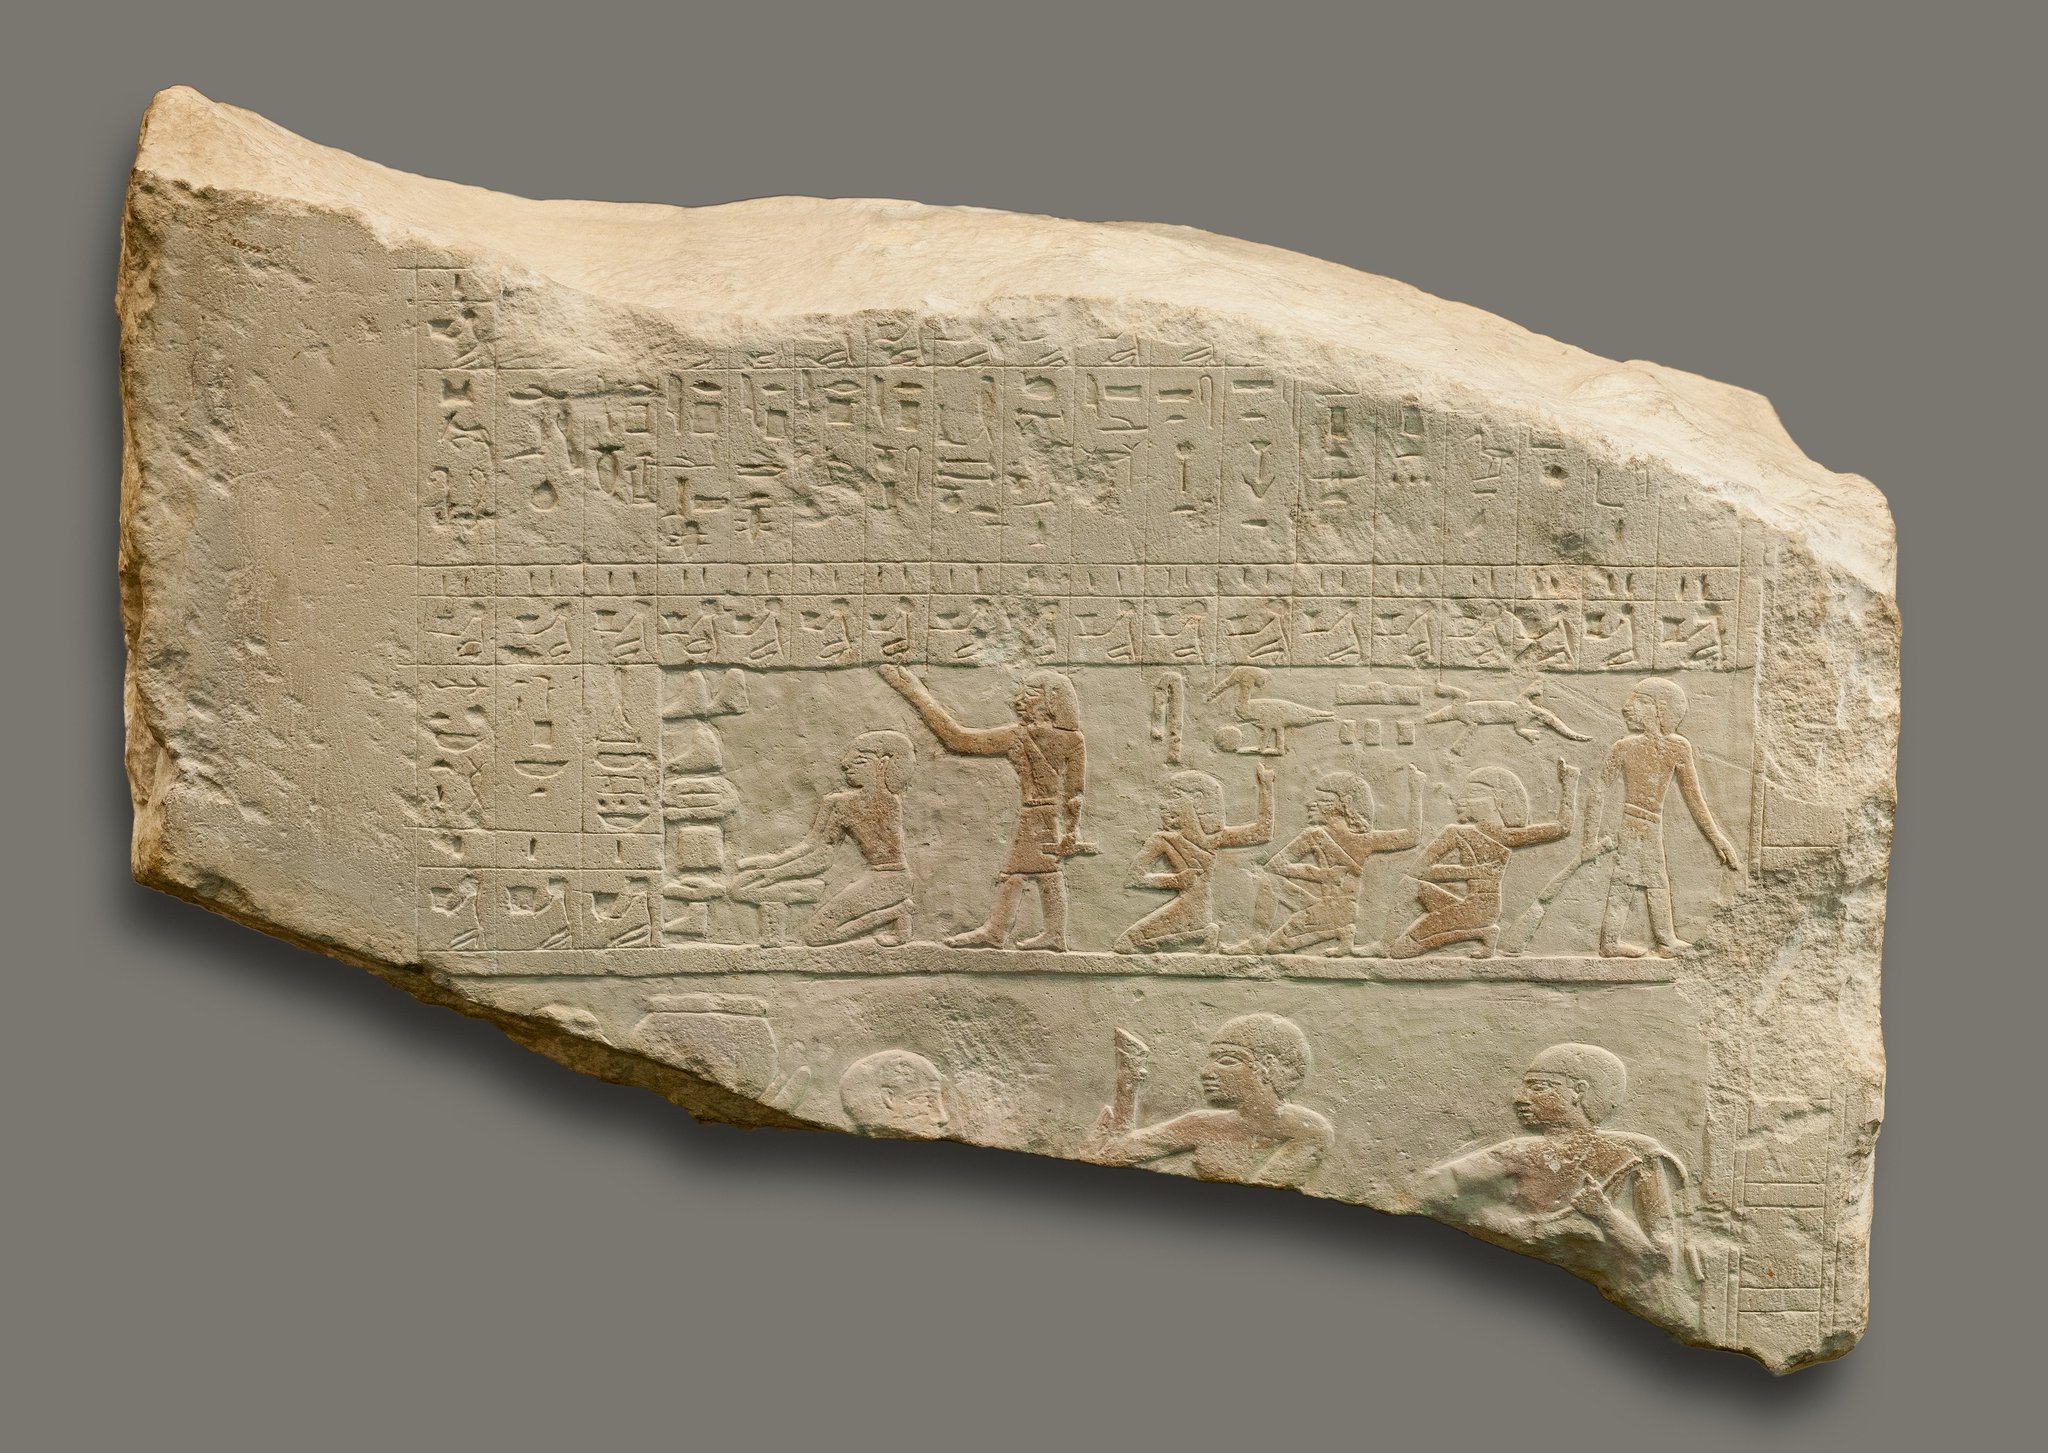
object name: relief, offering niche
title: Relief from an Offering Niche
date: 2100-2010 BCE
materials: limestone, paint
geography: egypt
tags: hieroglyphs